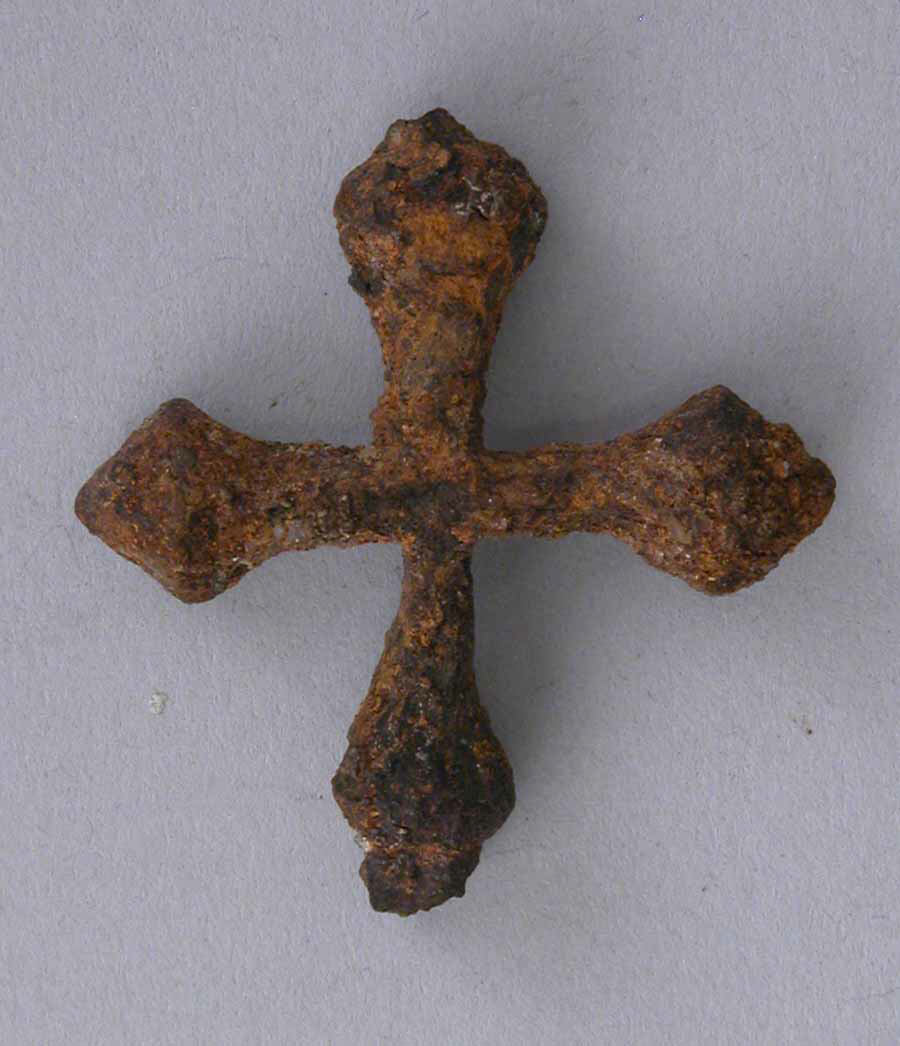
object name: cross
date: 201-1200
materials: iron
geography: egypt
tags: cross